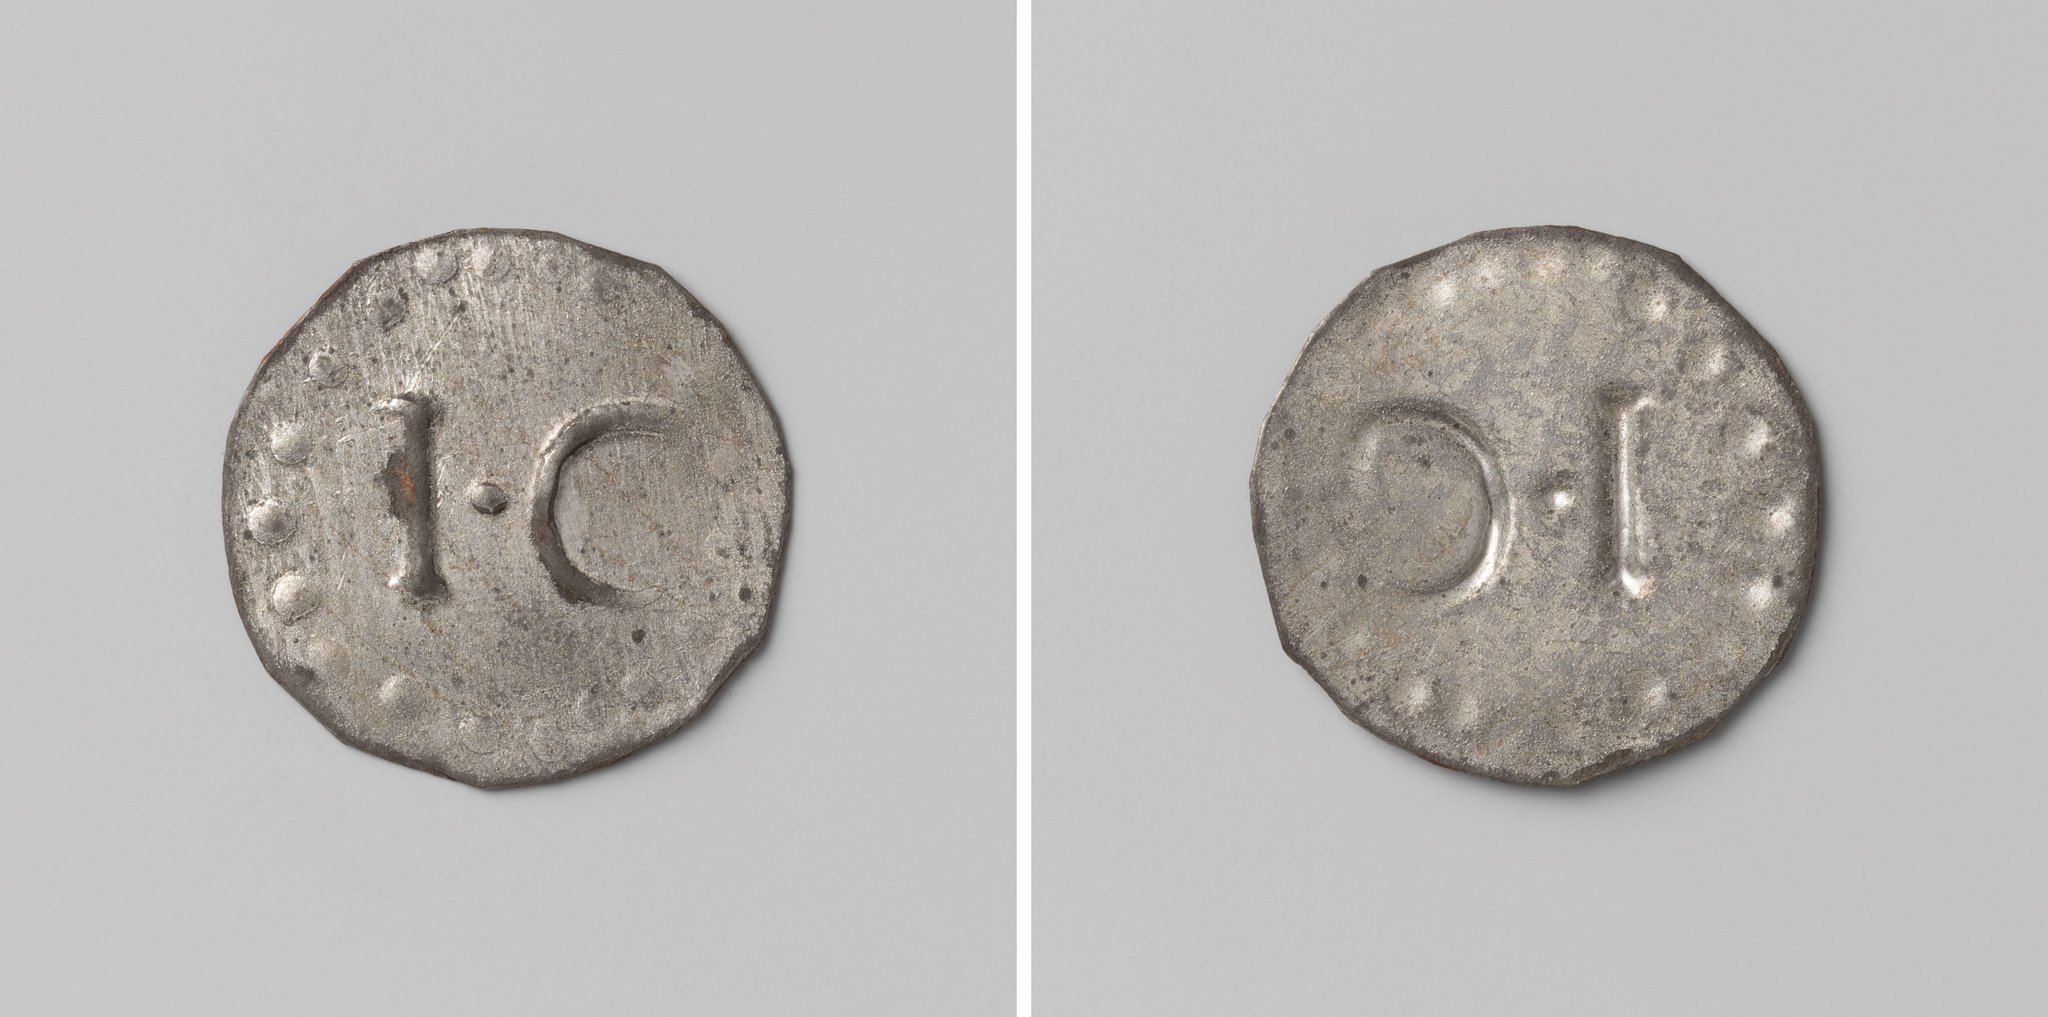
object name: huismunt prison money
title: Strafgevangenis Ommerschans, huismunt geslagen op last van de Maatschappij van Weldadigheid ter waarde van 1 cent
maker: Anonymous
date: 1822-1830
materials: silver, metal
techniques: silvering, striking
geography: ommerschans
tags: maatschappij van weldadigheid, ommerschans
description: eenzijdige munt. Voorzijde: waardeaanduiding binnen parelrand. Keerzijde: blanco